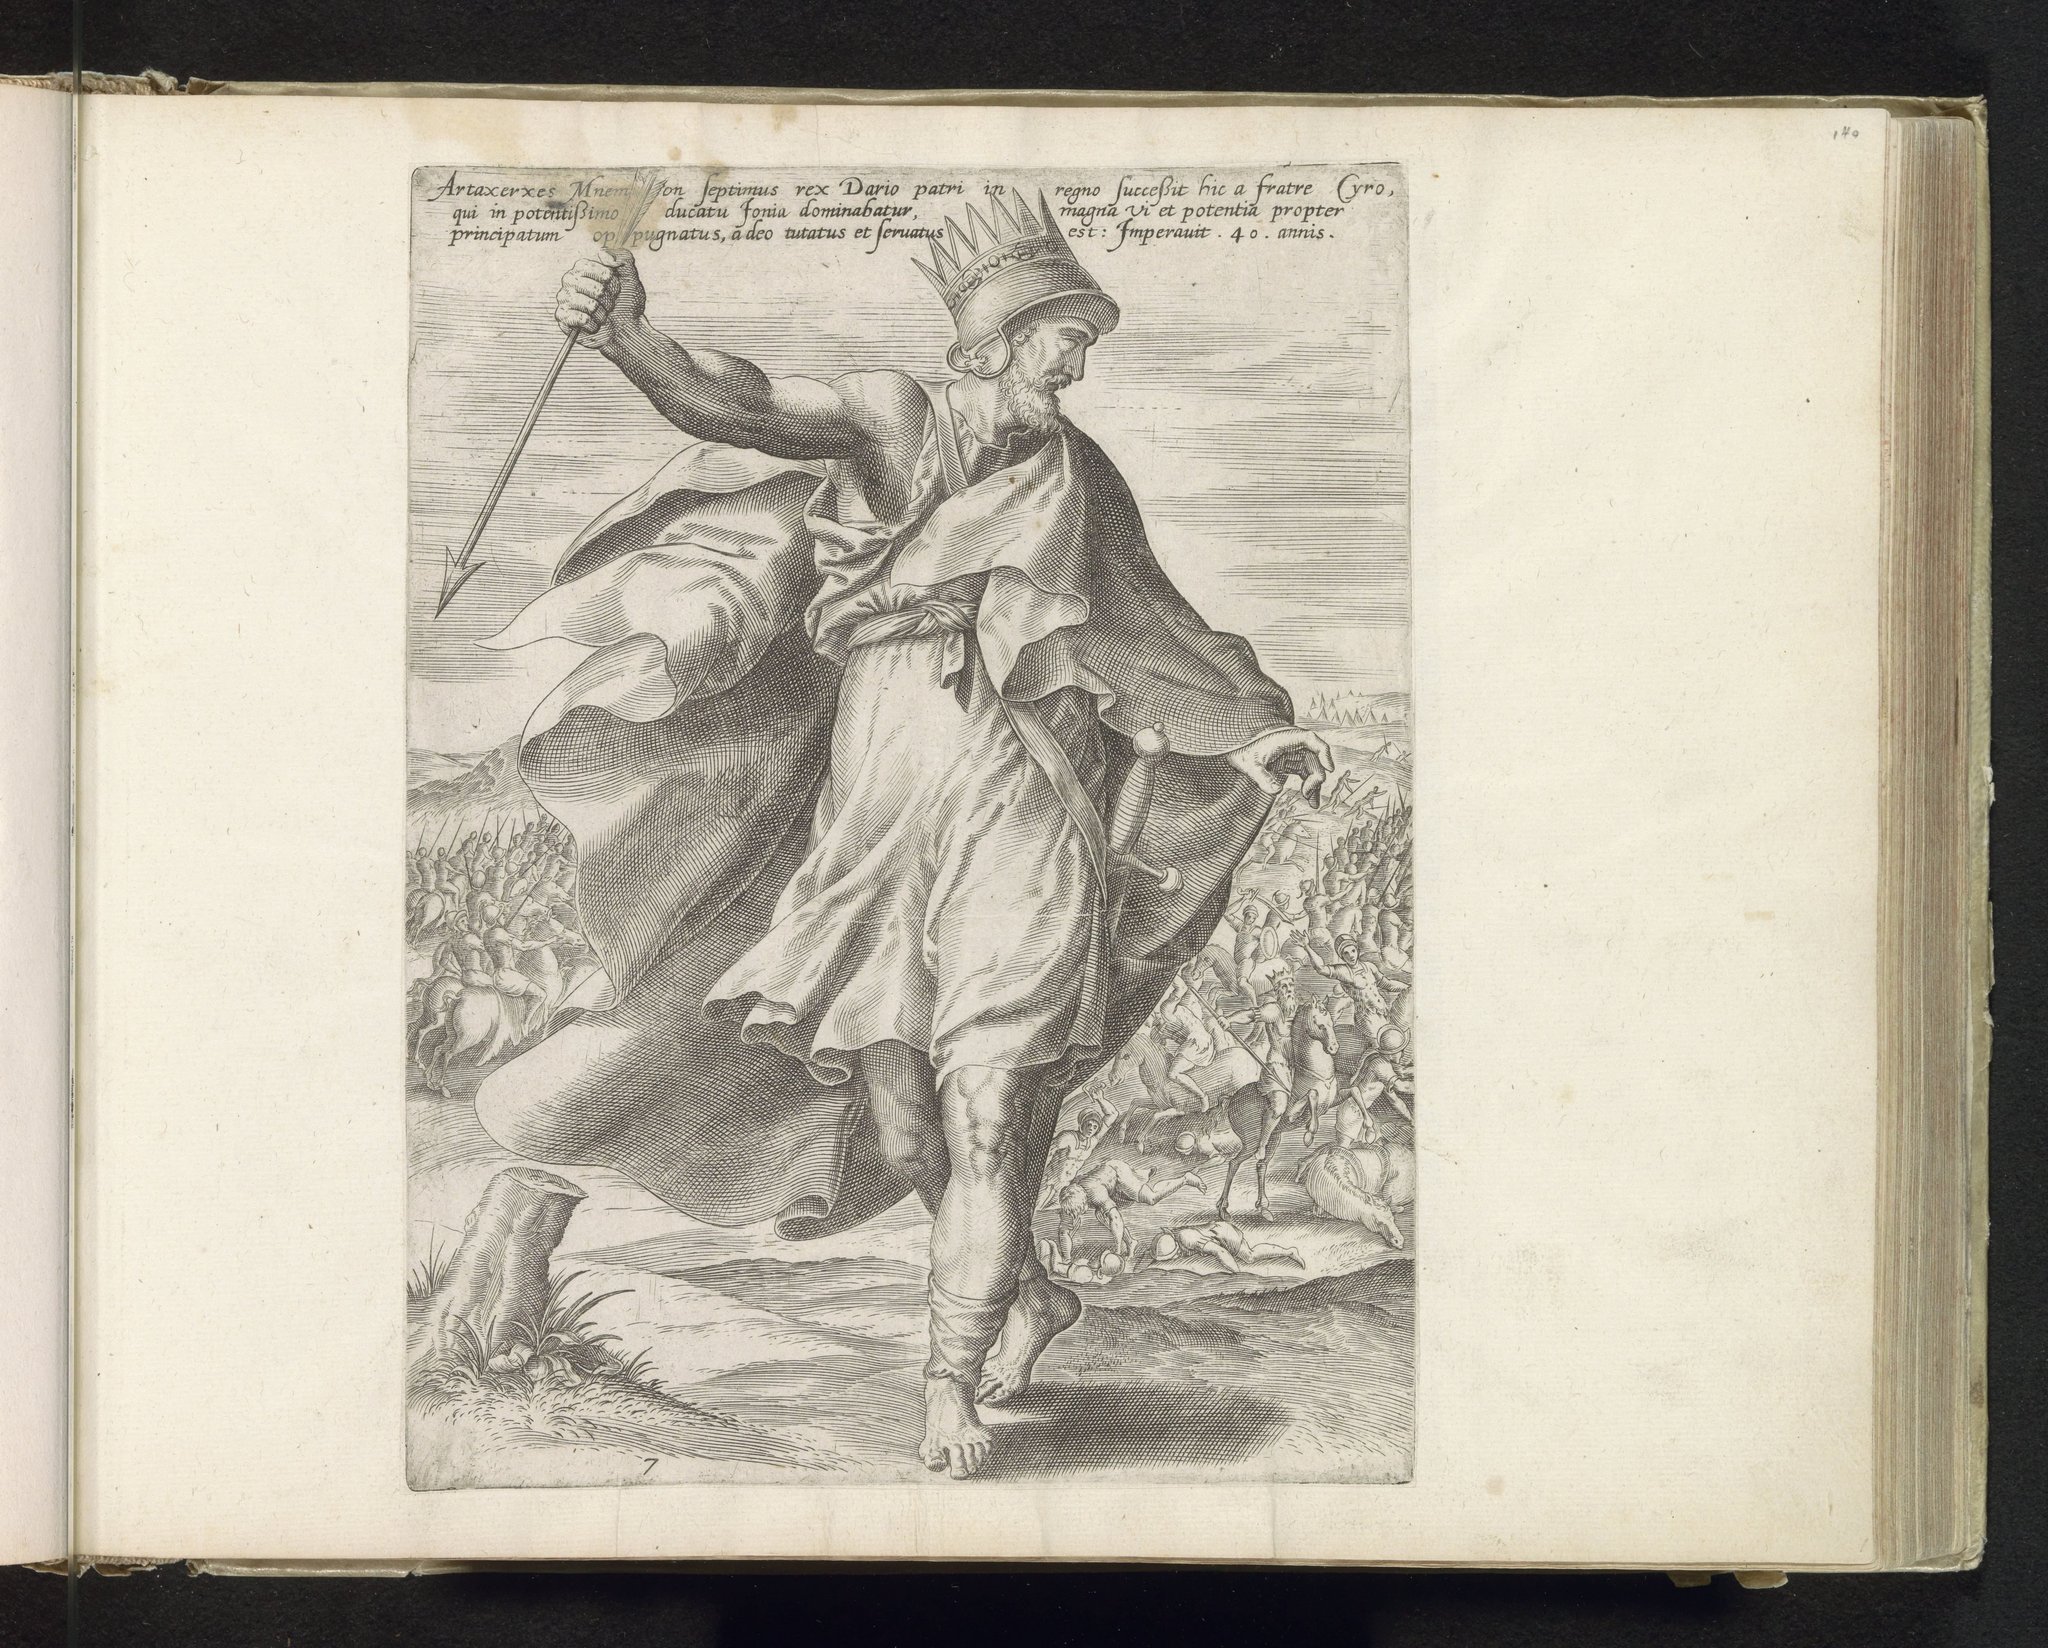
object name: print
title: Koning Artaxerxes II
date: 1585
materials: paper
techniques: engraving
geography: antwerp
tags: battle, male persons from classical history, ruler, sovereign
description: Koning Artaxerxes II van Perzië staande met een pijl in zijn hand. Op de achtergrond is te zien hoe Artaxerxes zijn jongere broer Cyrus verslaat, die tegen hem in opstand was gekomen. Boven de voorstelling een drieregelige tekst in het Latijn. Deze prent maakt deel uit van een album.